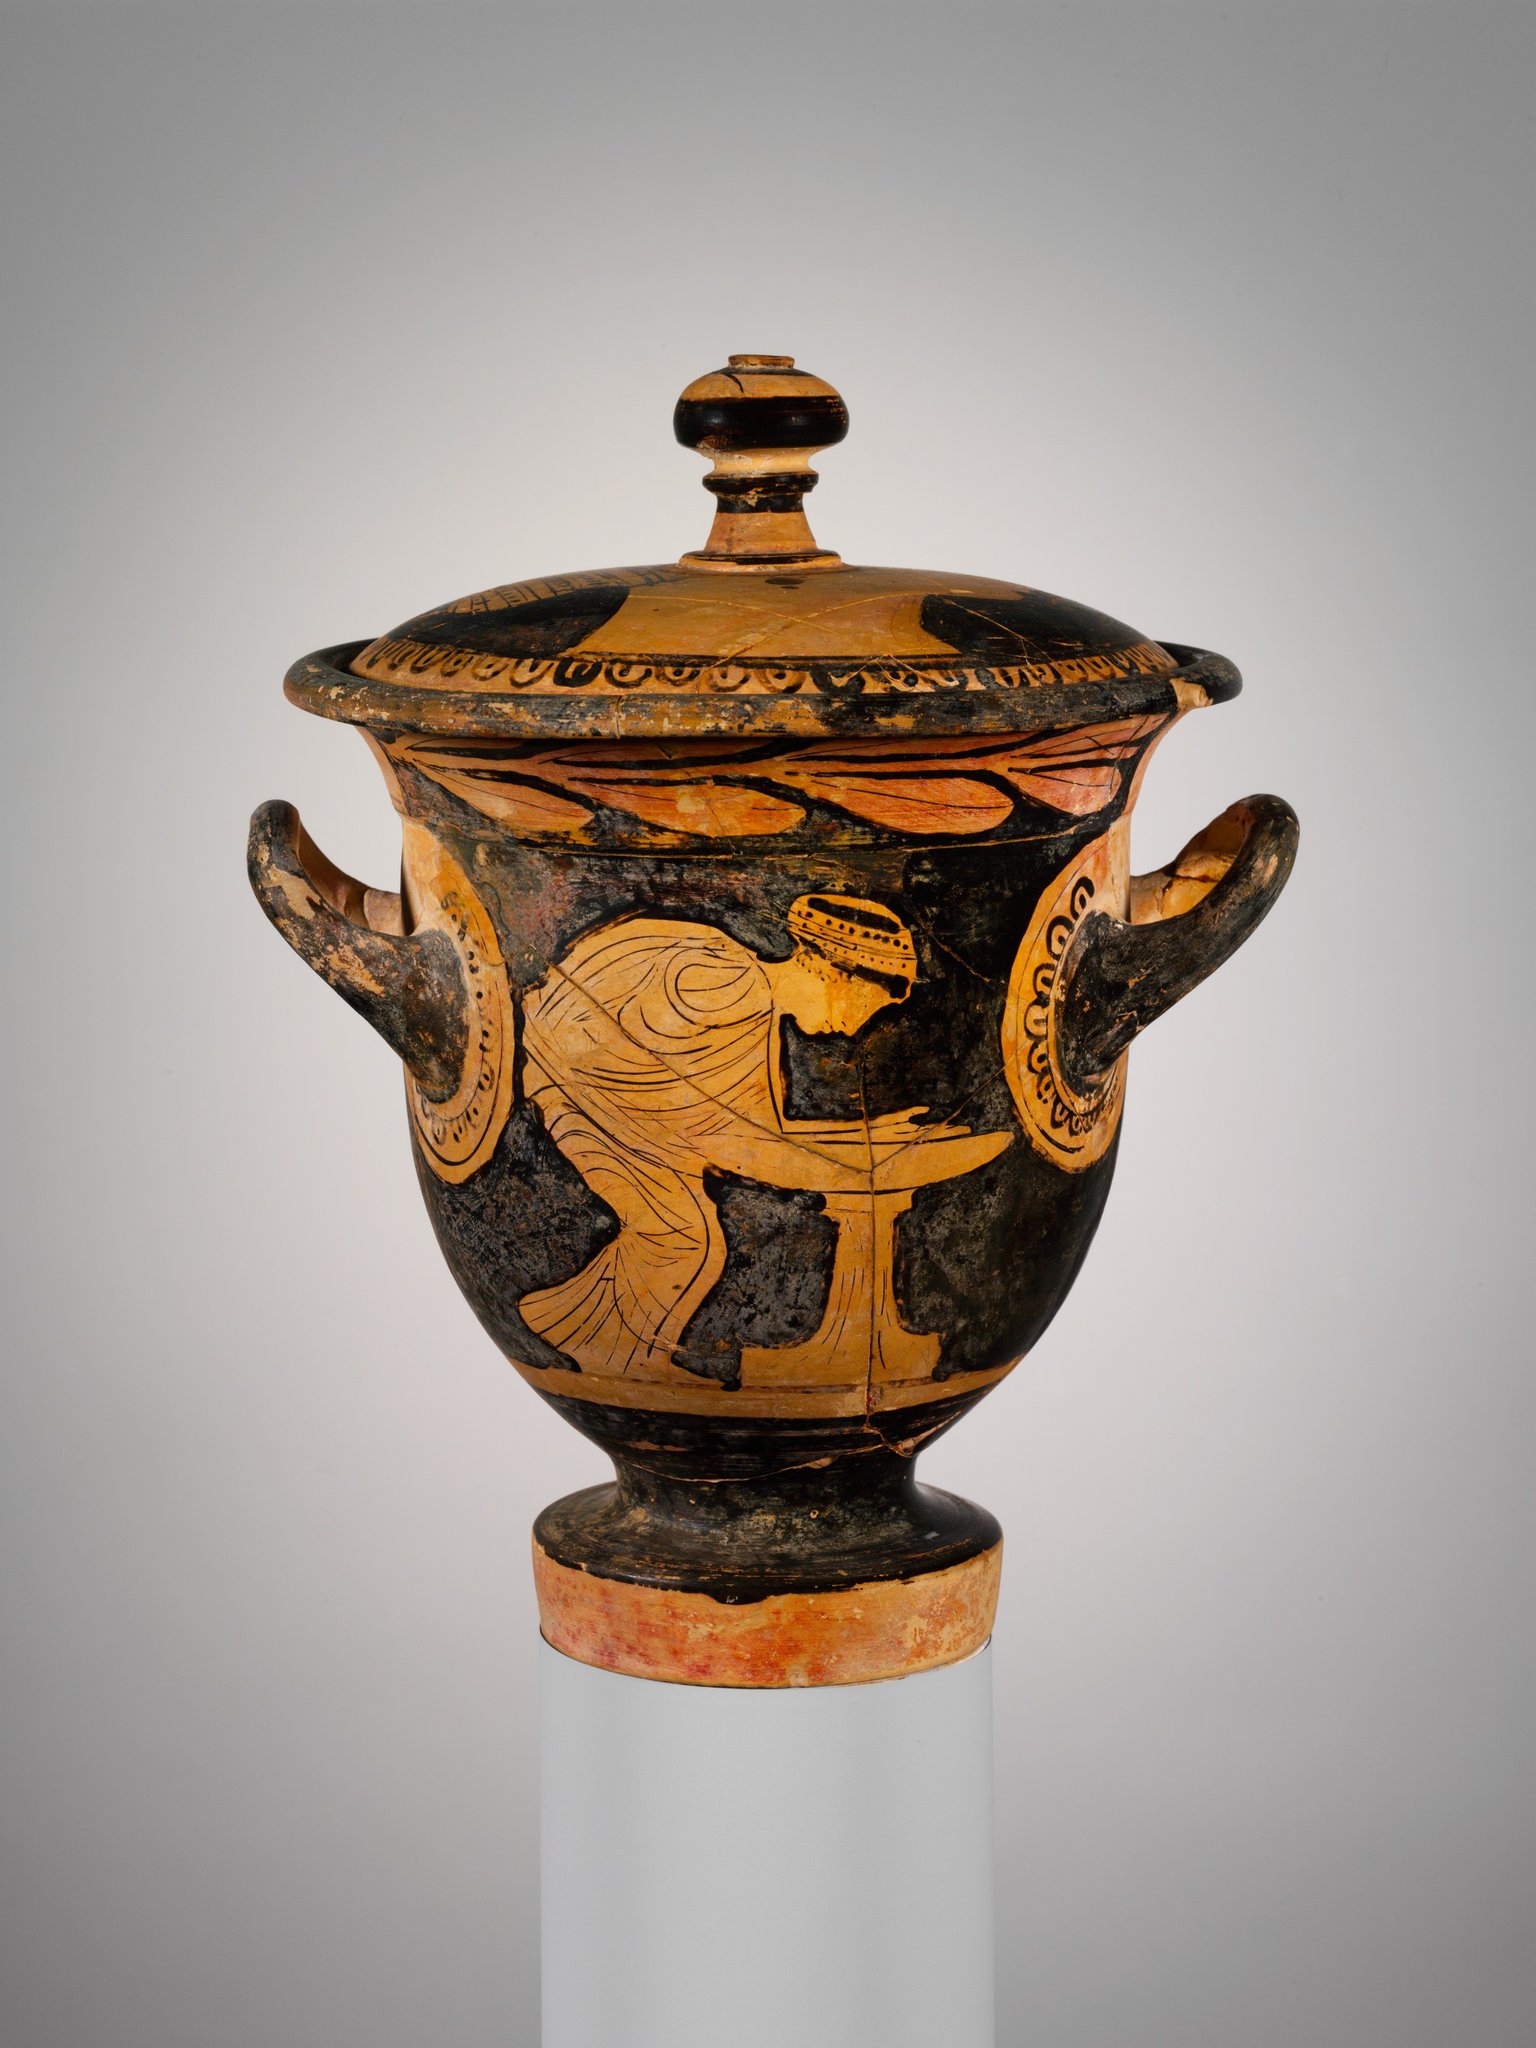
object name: bell krater with lid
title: Terracotta bell-krater (mixing bowl) with lid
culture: greek, boeotian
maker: group of the würzburg scylla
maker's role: artist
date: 434-401 BCE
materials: terracotta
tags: women,monsters